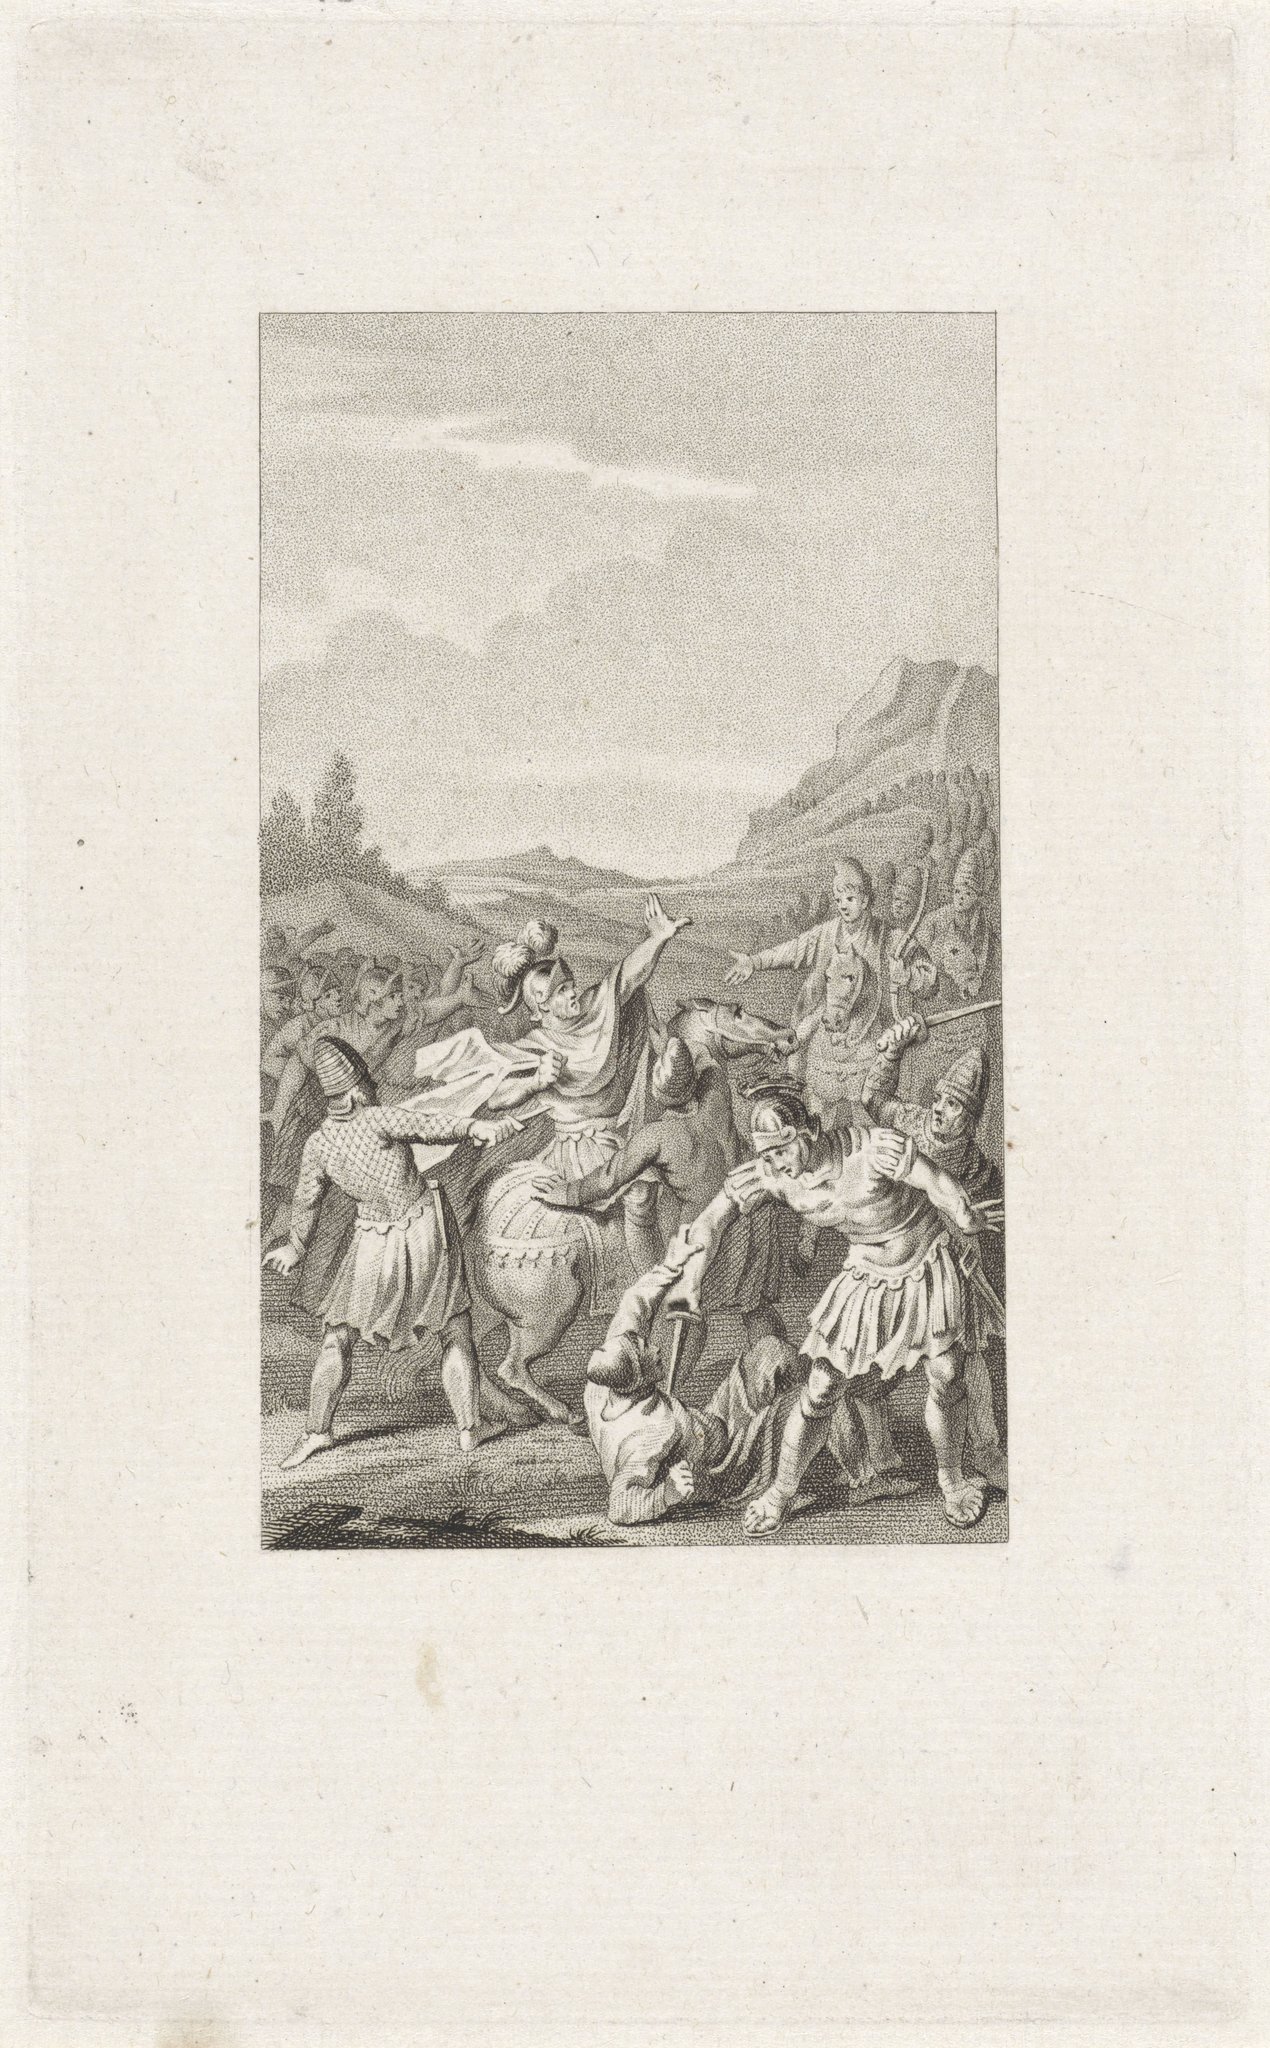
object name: print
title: Dood van Marcus Licinius Crassus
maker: ludwig gottlieb portman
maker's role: print maker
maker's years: 1772-1828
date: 1800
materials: paper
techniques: etching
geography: amsterdam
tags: suffering, misfortune of m. licinius crassus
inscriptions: collector's mark: Lugt 2228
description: Pomaxaethres, een Parthische soldaat, doodt Crassus die te paard probeert te vluchten. Octavius steekt een stalknecht neer en wordt tegelijkertijd zelf van achteren door de vijand aangevallen.